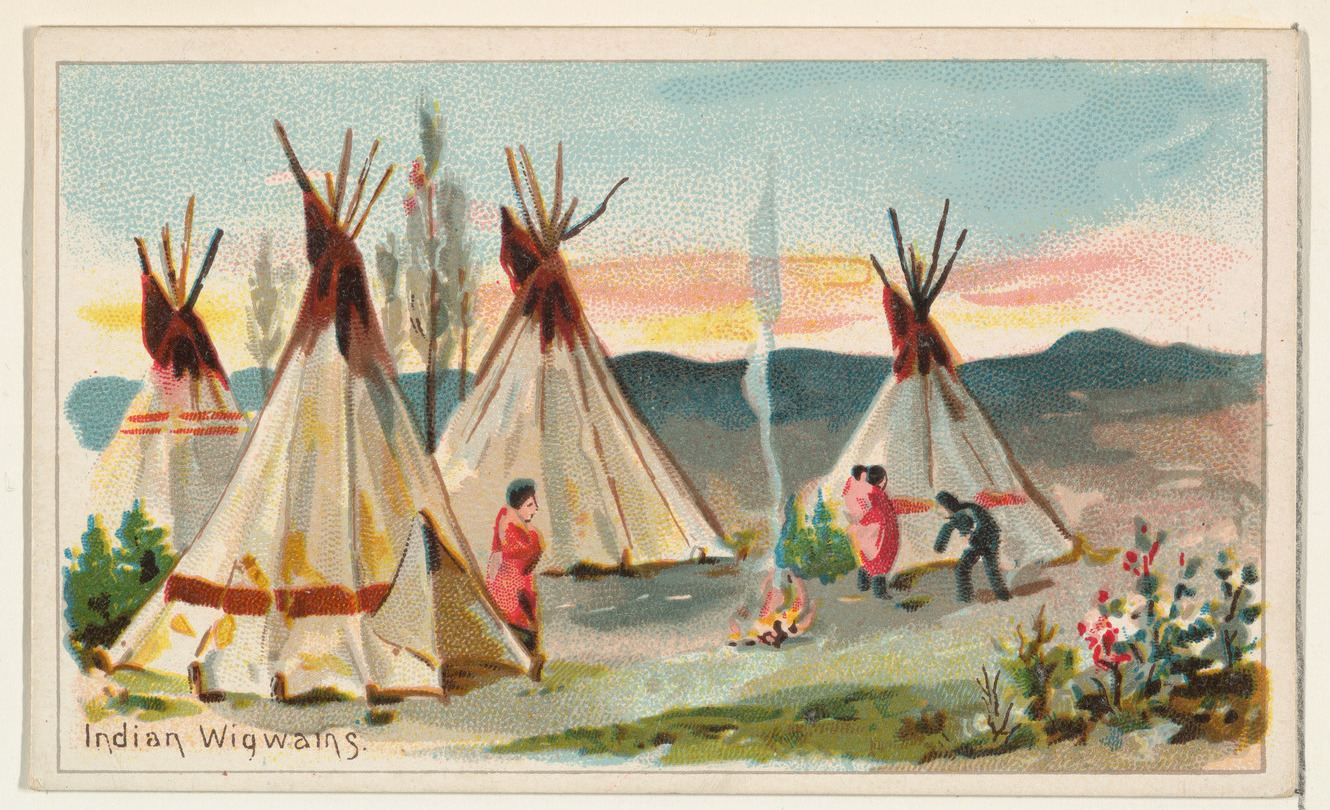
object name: print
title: Indian Wigwams, from the Habitations of Man series (N113) issued by W. Duke, Sons & Co. to promote Honest Long Cut Smoking and Chewing Tobacco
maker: the giles company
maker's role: artist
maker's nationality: american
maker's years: 1800-1900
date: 1890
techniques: color lithograph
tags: tents